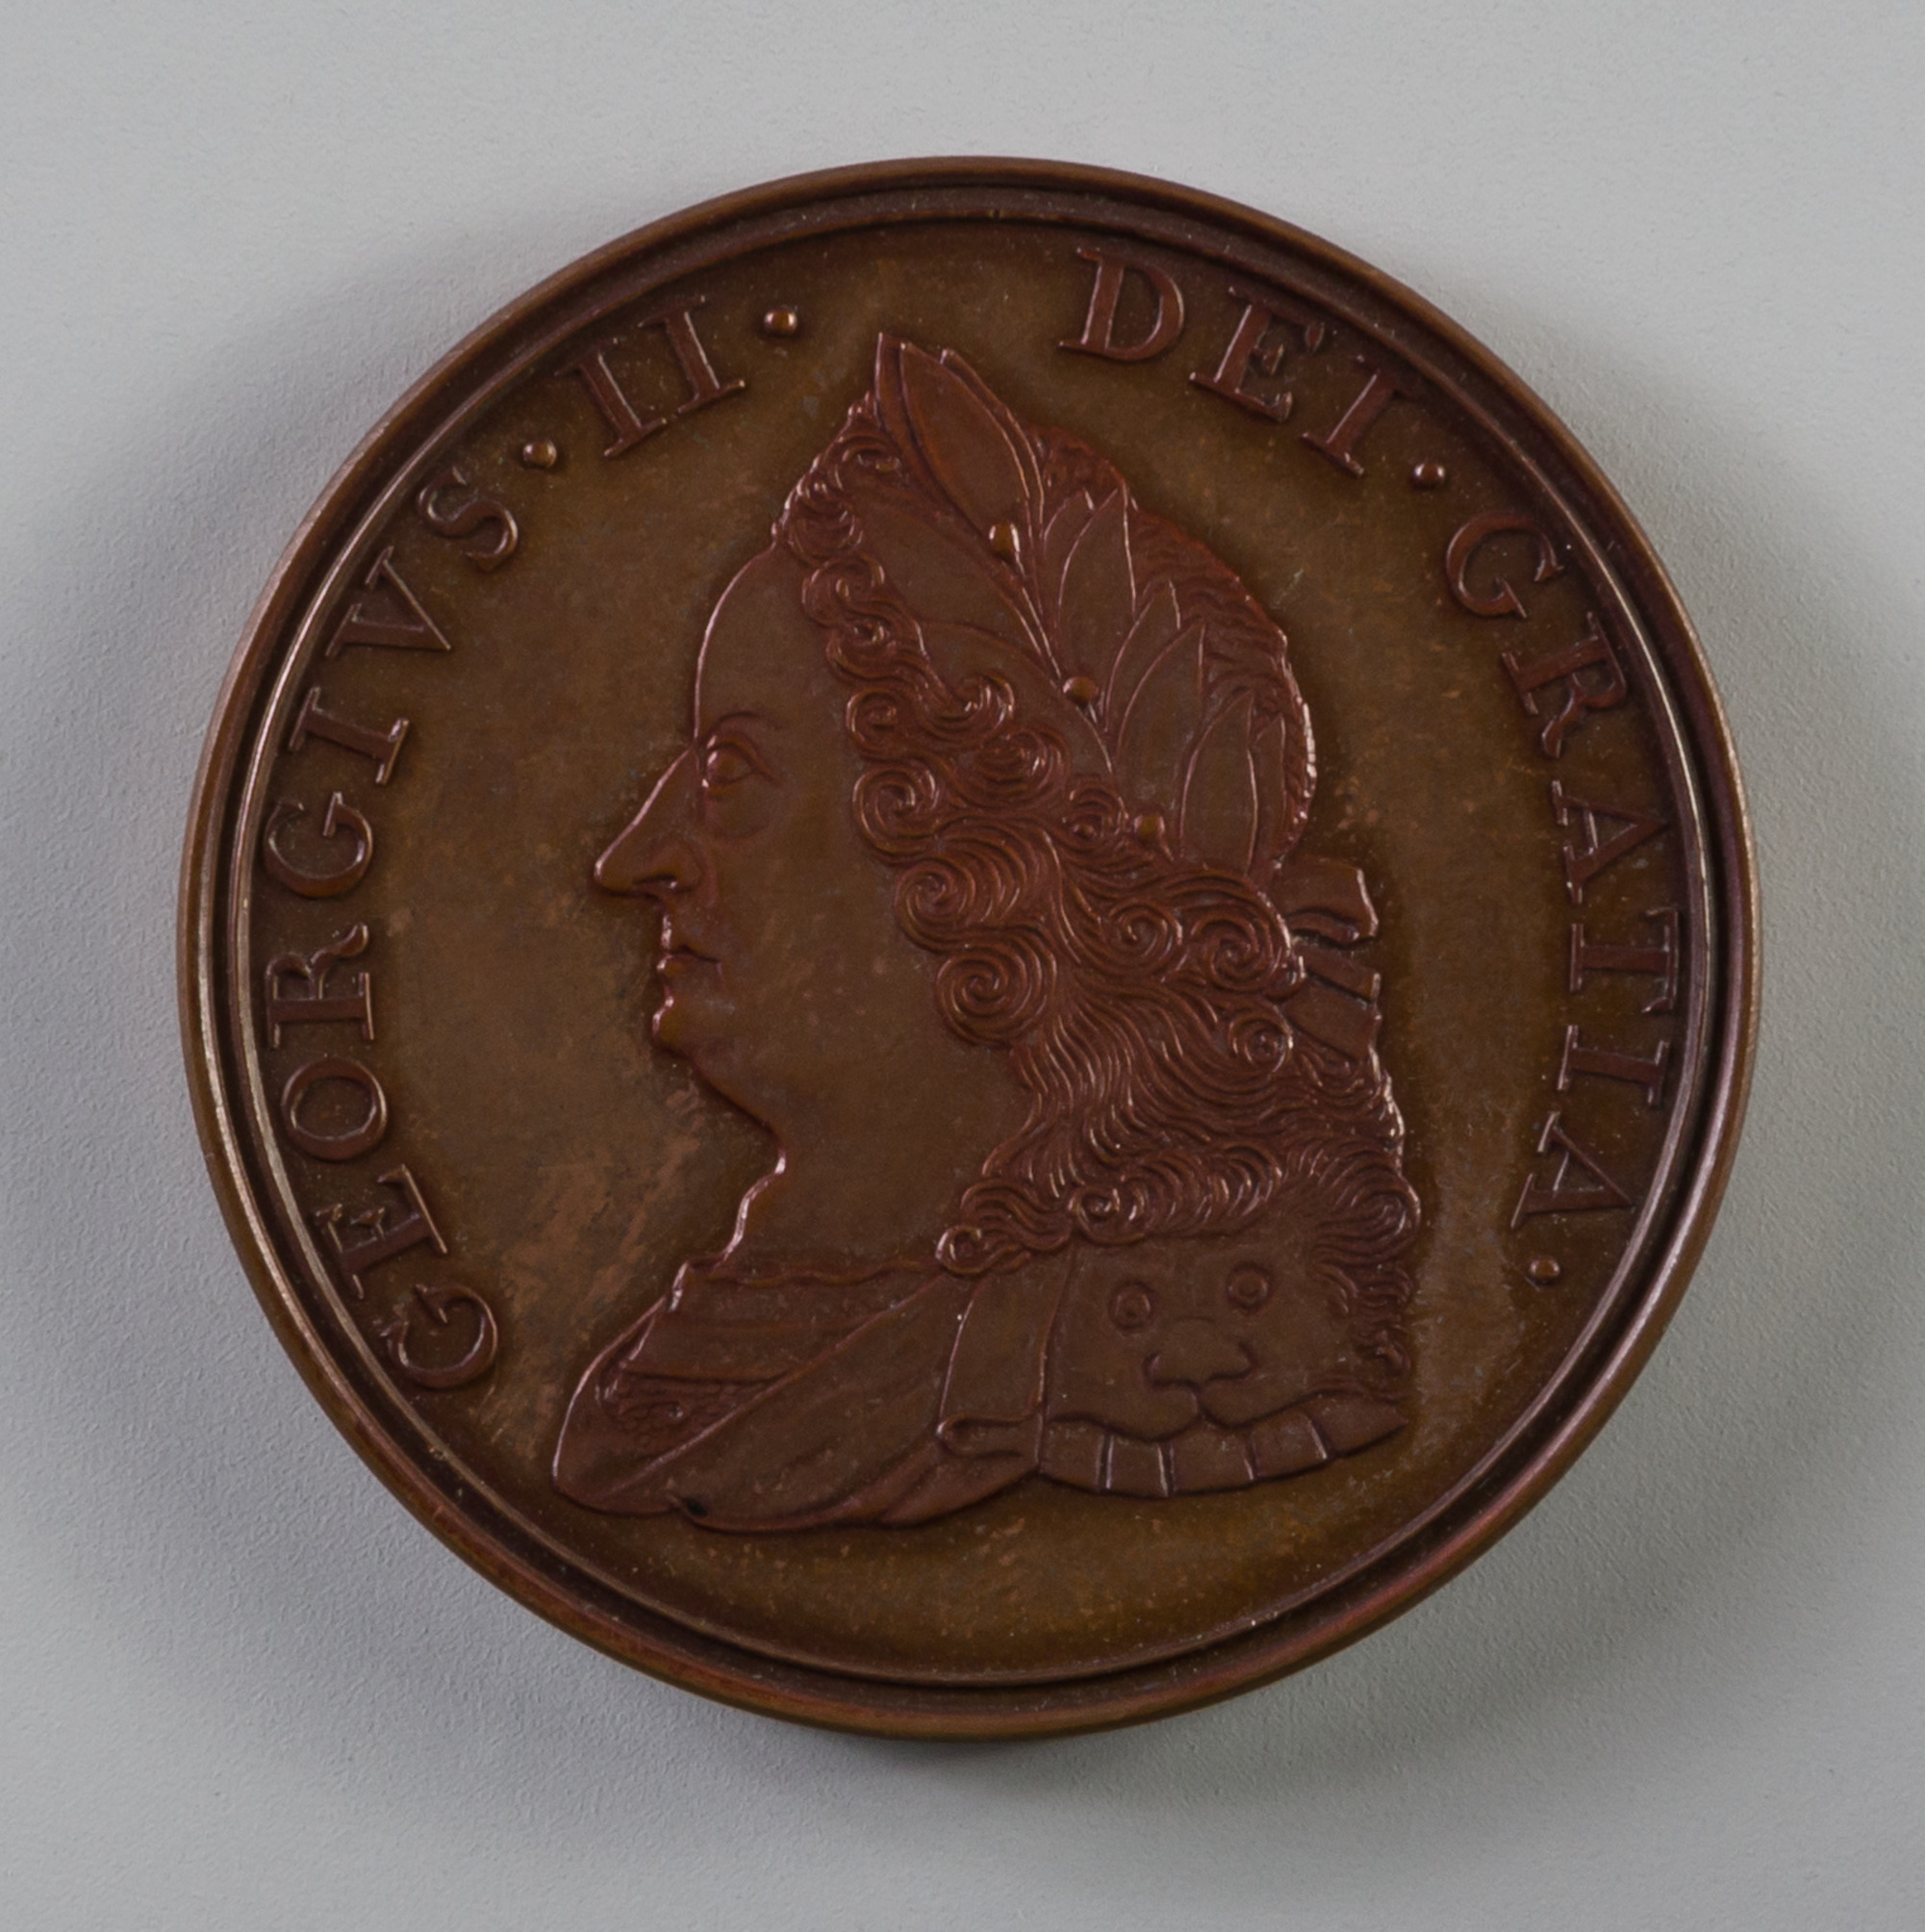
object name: medal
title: Indian Medal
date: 1757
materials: bronze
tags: men,profiles